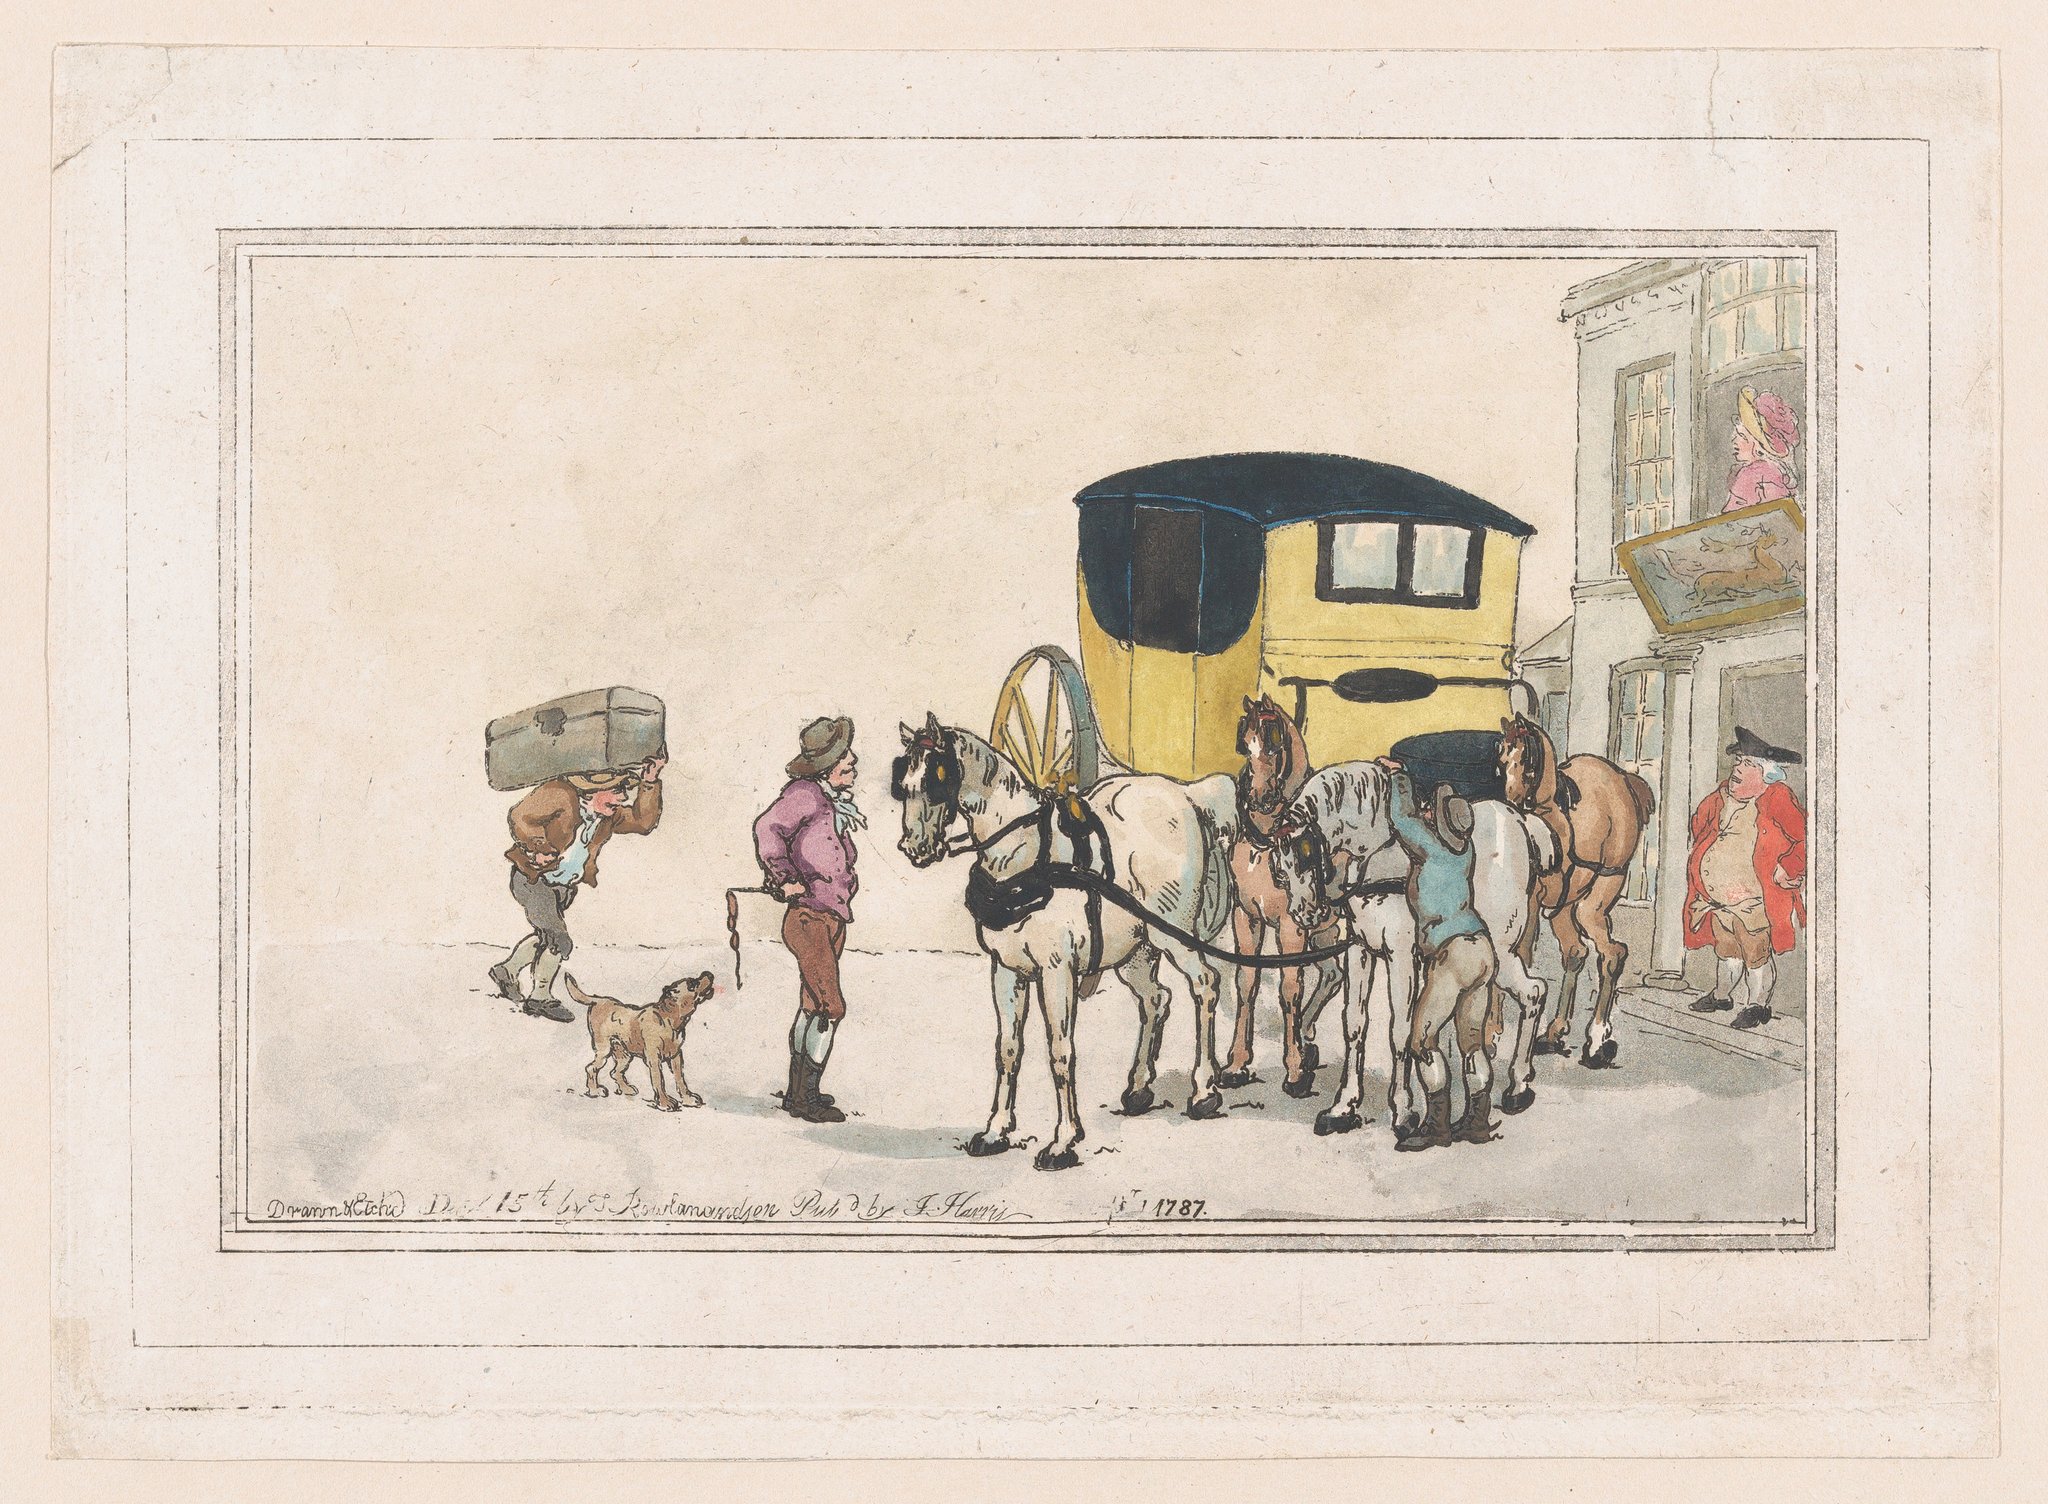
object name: print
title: Post Boys and Post Horses at the White Hart Inn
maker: thomas rowlandson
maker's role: artist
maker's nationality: british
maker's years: 1757-1827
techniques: aquatint, etching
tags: inns,men,dogs,horses,carriages